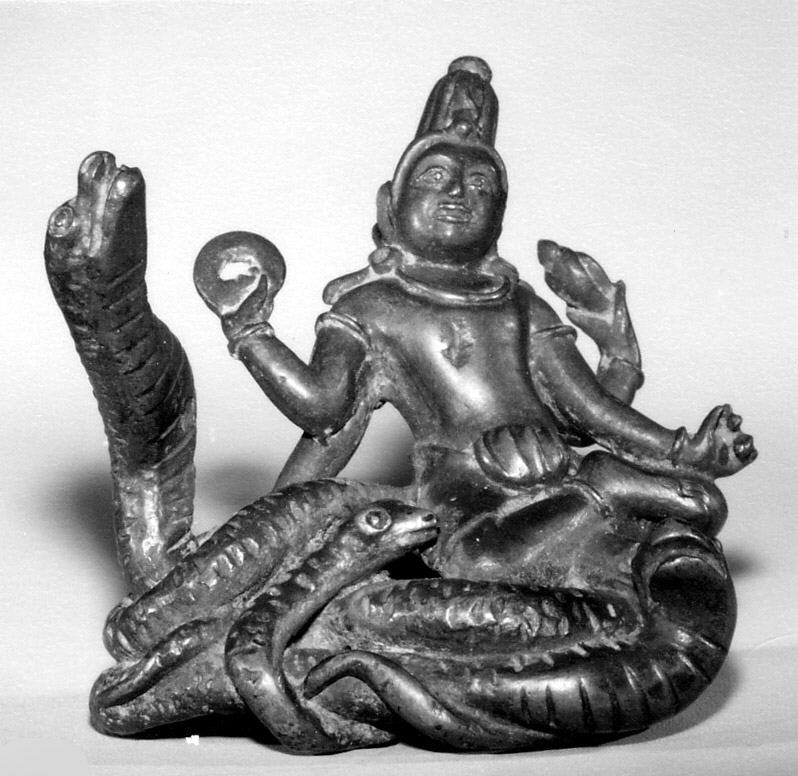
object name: figure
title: Vishnu on Adisesha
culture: indonesia or thailand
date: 1001-1200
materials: bronze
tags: serpents,vishnu,hinduism